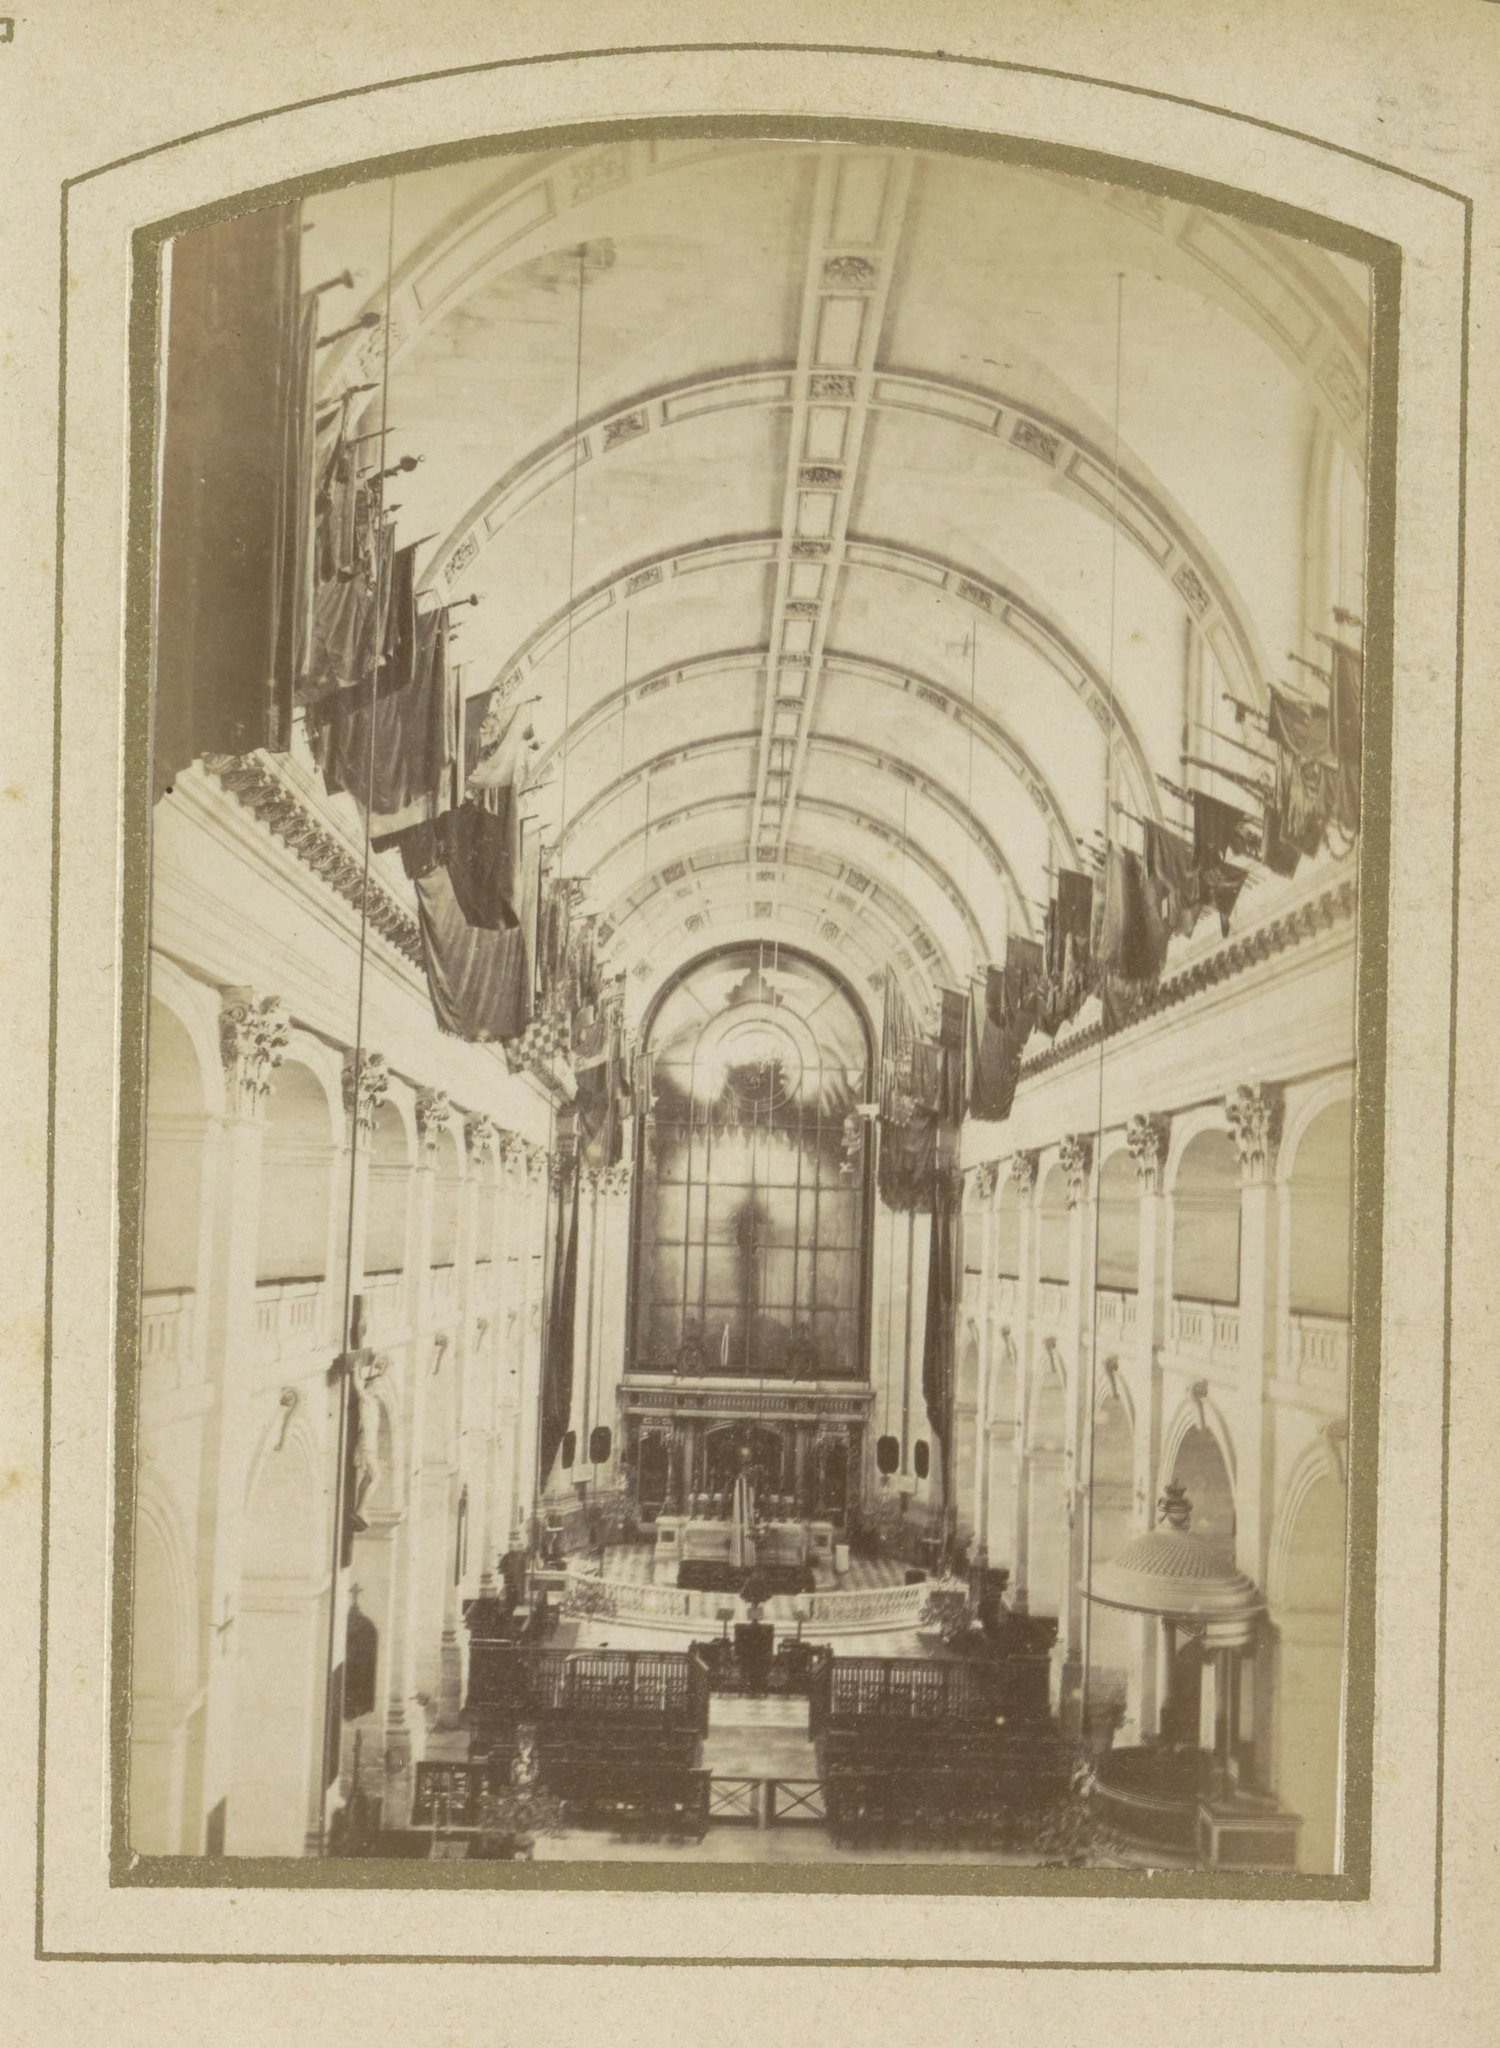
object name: photograph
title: Schip en gewelf van de Chapelle Saint Louis in het Hôtel des Invalides in Parijs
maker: Anonymous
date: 1870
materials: cardboard, paper, photographic support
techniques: albumen print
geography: paris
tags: parts of church interior: vault, parts of church interior: nave, paris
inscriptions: inscription: ‘Chapelle des Invalides’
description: Onderdeel van Fotoalbum met kabinetfoto's van bezienswaardigheden in Parijs.